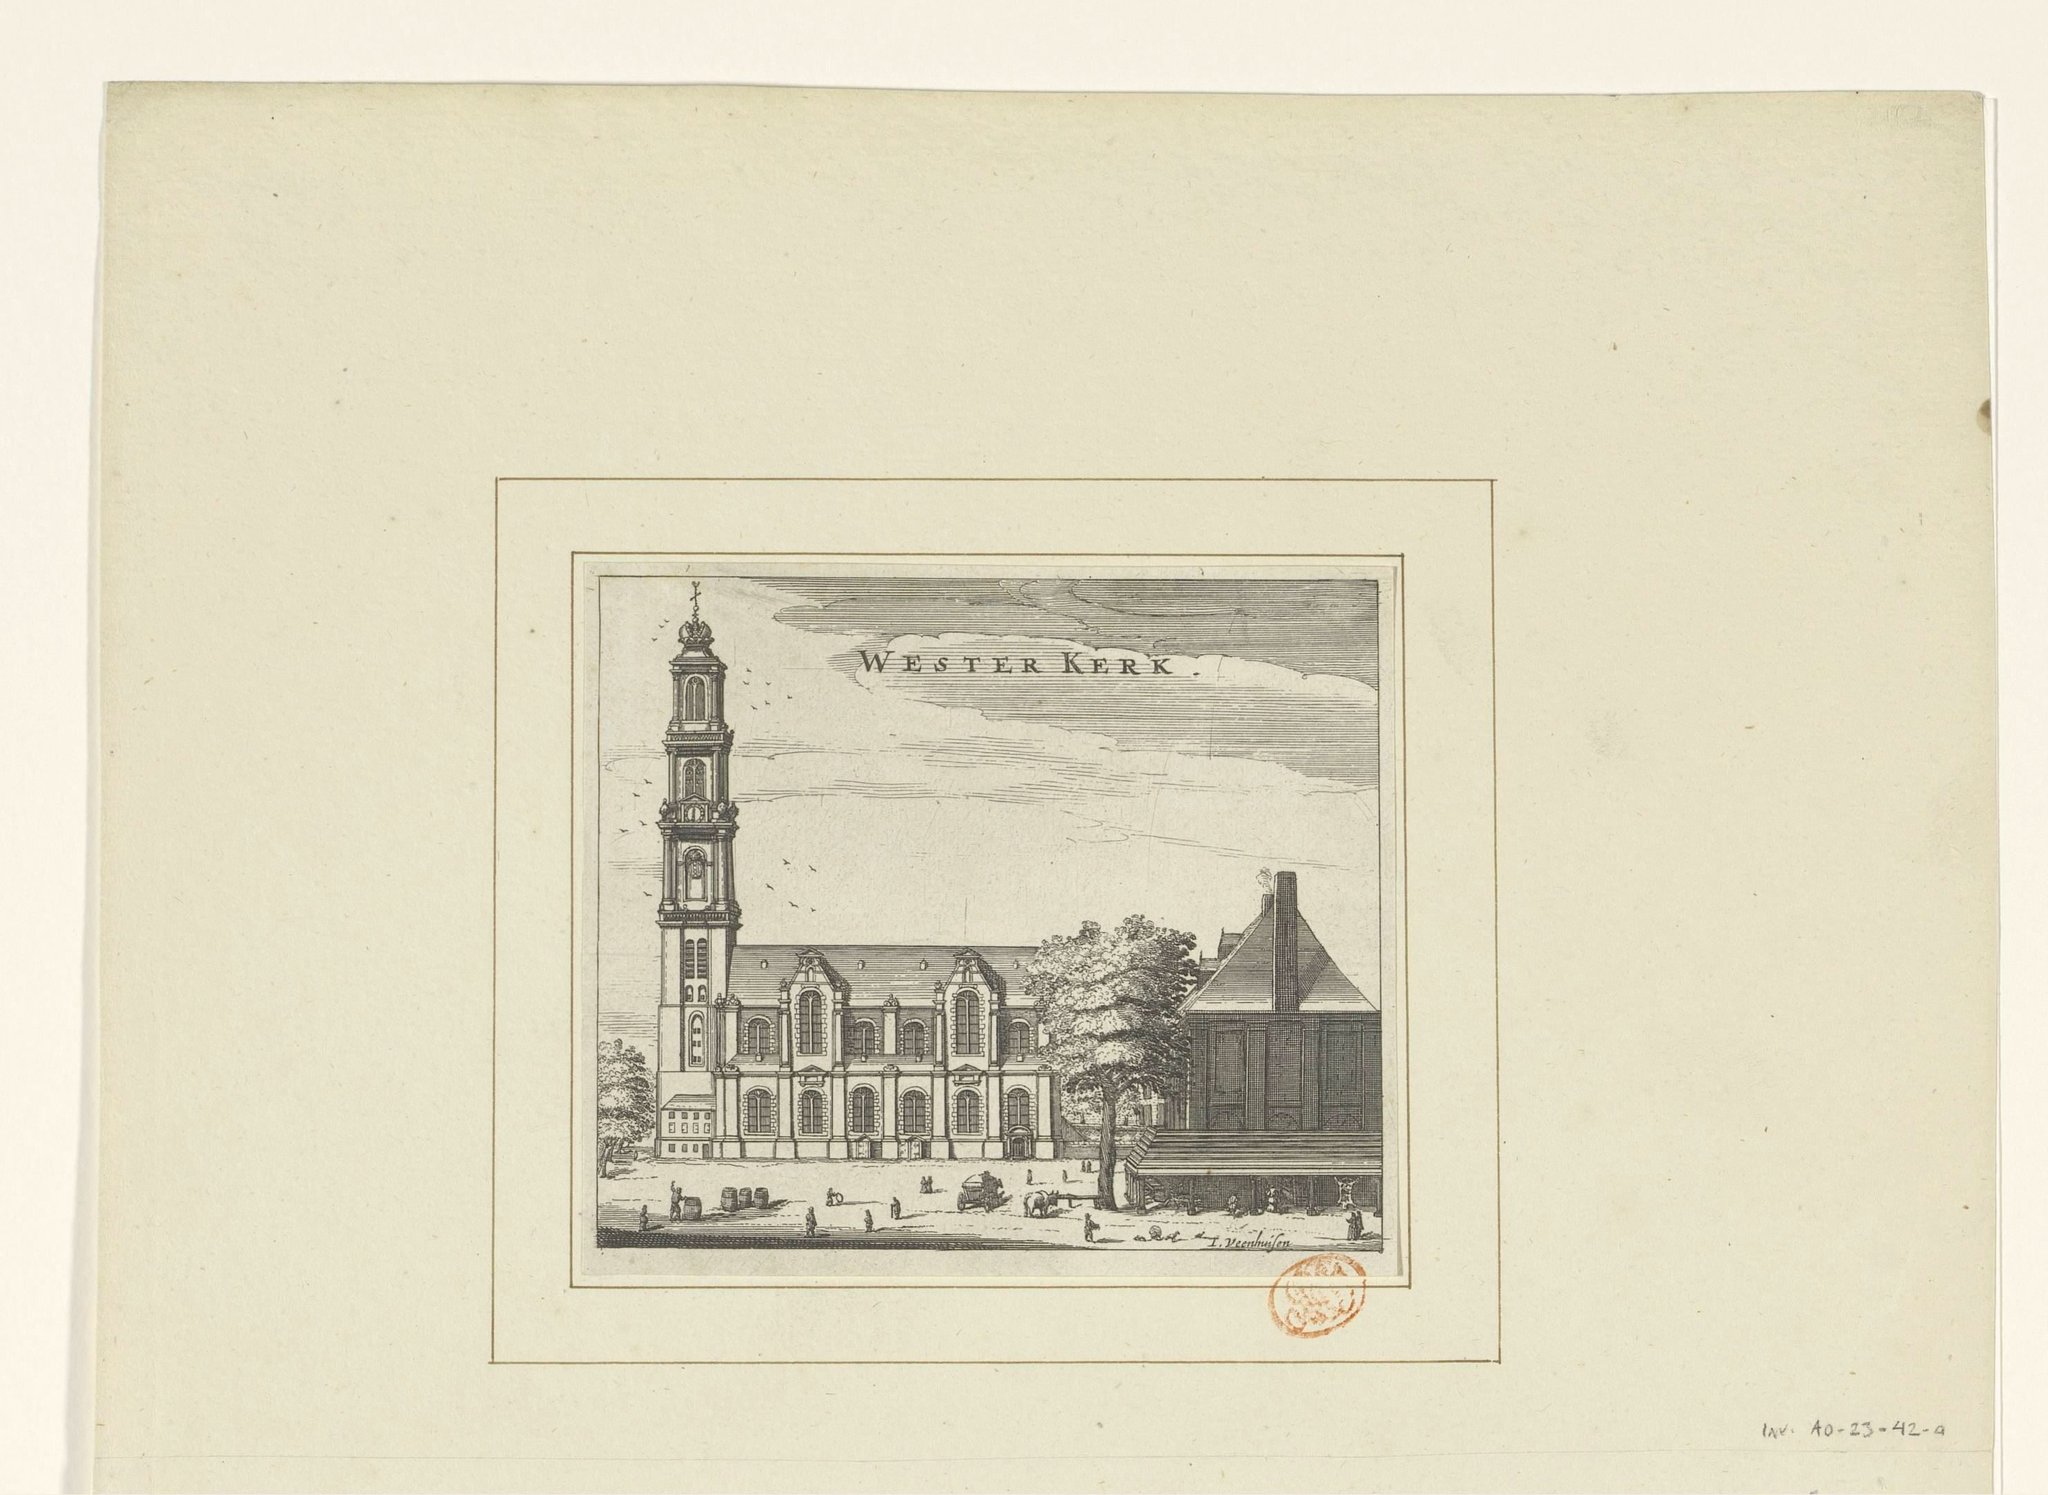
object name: book illustration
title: Gezicht op de Westerkerk te Amsterdam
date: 1664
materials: paper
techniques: engraving, etching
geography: amsterdam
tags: church (exterior)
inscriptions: collector's mark: Lugt 195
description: Huidige staat van prent ook gebruikt in: Fockens, Melchior. Beschrijving Der wijdt-vermaarde Koop-stadt Amstelredam, Van haar eerste beginselen, zedert den Jare 1203. oude Voorrechten, verscheyde Vergrootingenoude Voor-rechten, en verscheyde Vergrootingen (…). 3e druk. Amsterdam: Marcus Willemsz. Doornick, 1664. En in: Zesen, Philipp von. Beschrybung der Weidtberuhmde Kauf-Stadt Amstelredam / Beschreibung der Stadt Amsterdam darinnen von derselben ersten ursprunge bis auf gegenwartigen zustand (…). Amsterdam: Marcus Willemsz. Doornick, 1664. Eerste bekende staat van prent (rechtsboven genummerd: 228) ook gebruikt in: Fockens, Melchior. Beschrijvinge Der wijdt-vermaarde Koop-stadt Amstelredam, Van hare eerste beginselen, oude Voor-rechten, en verscheyde Vergrootingen (…). 1e druk. Amsterdam: Marcus Willemsz. Doornick, 1662. En in: Fockens, Melchior. Beschrijvinge Der wijdt-vermaarde Koop-stadt Amstelredam, Van hare eerste beginselen, oude Voor-rechten, en verscheyde Vergrootingen (…). 2e druk. Amsterdam: Marcus Willemsz. Doornick, 1662. Derde bekende staat (met toevoeging Franse titel) ook gebruikt in: Domselaer, Tobias en Isaac Commelin. Beschryvinge van Amsterdam : haar eerste oorspronk uyt den huyze der heeren van Aemstel en Aemstellant (…). 6 delen. Amsterdam: Marcus Willemsz van Doornick, 1665. Vierde bekende staat (rechtsboven genummerd: 13) ook gebruikt in verschillende latere zeventiende- en achttiende-eeuwse publicaties.